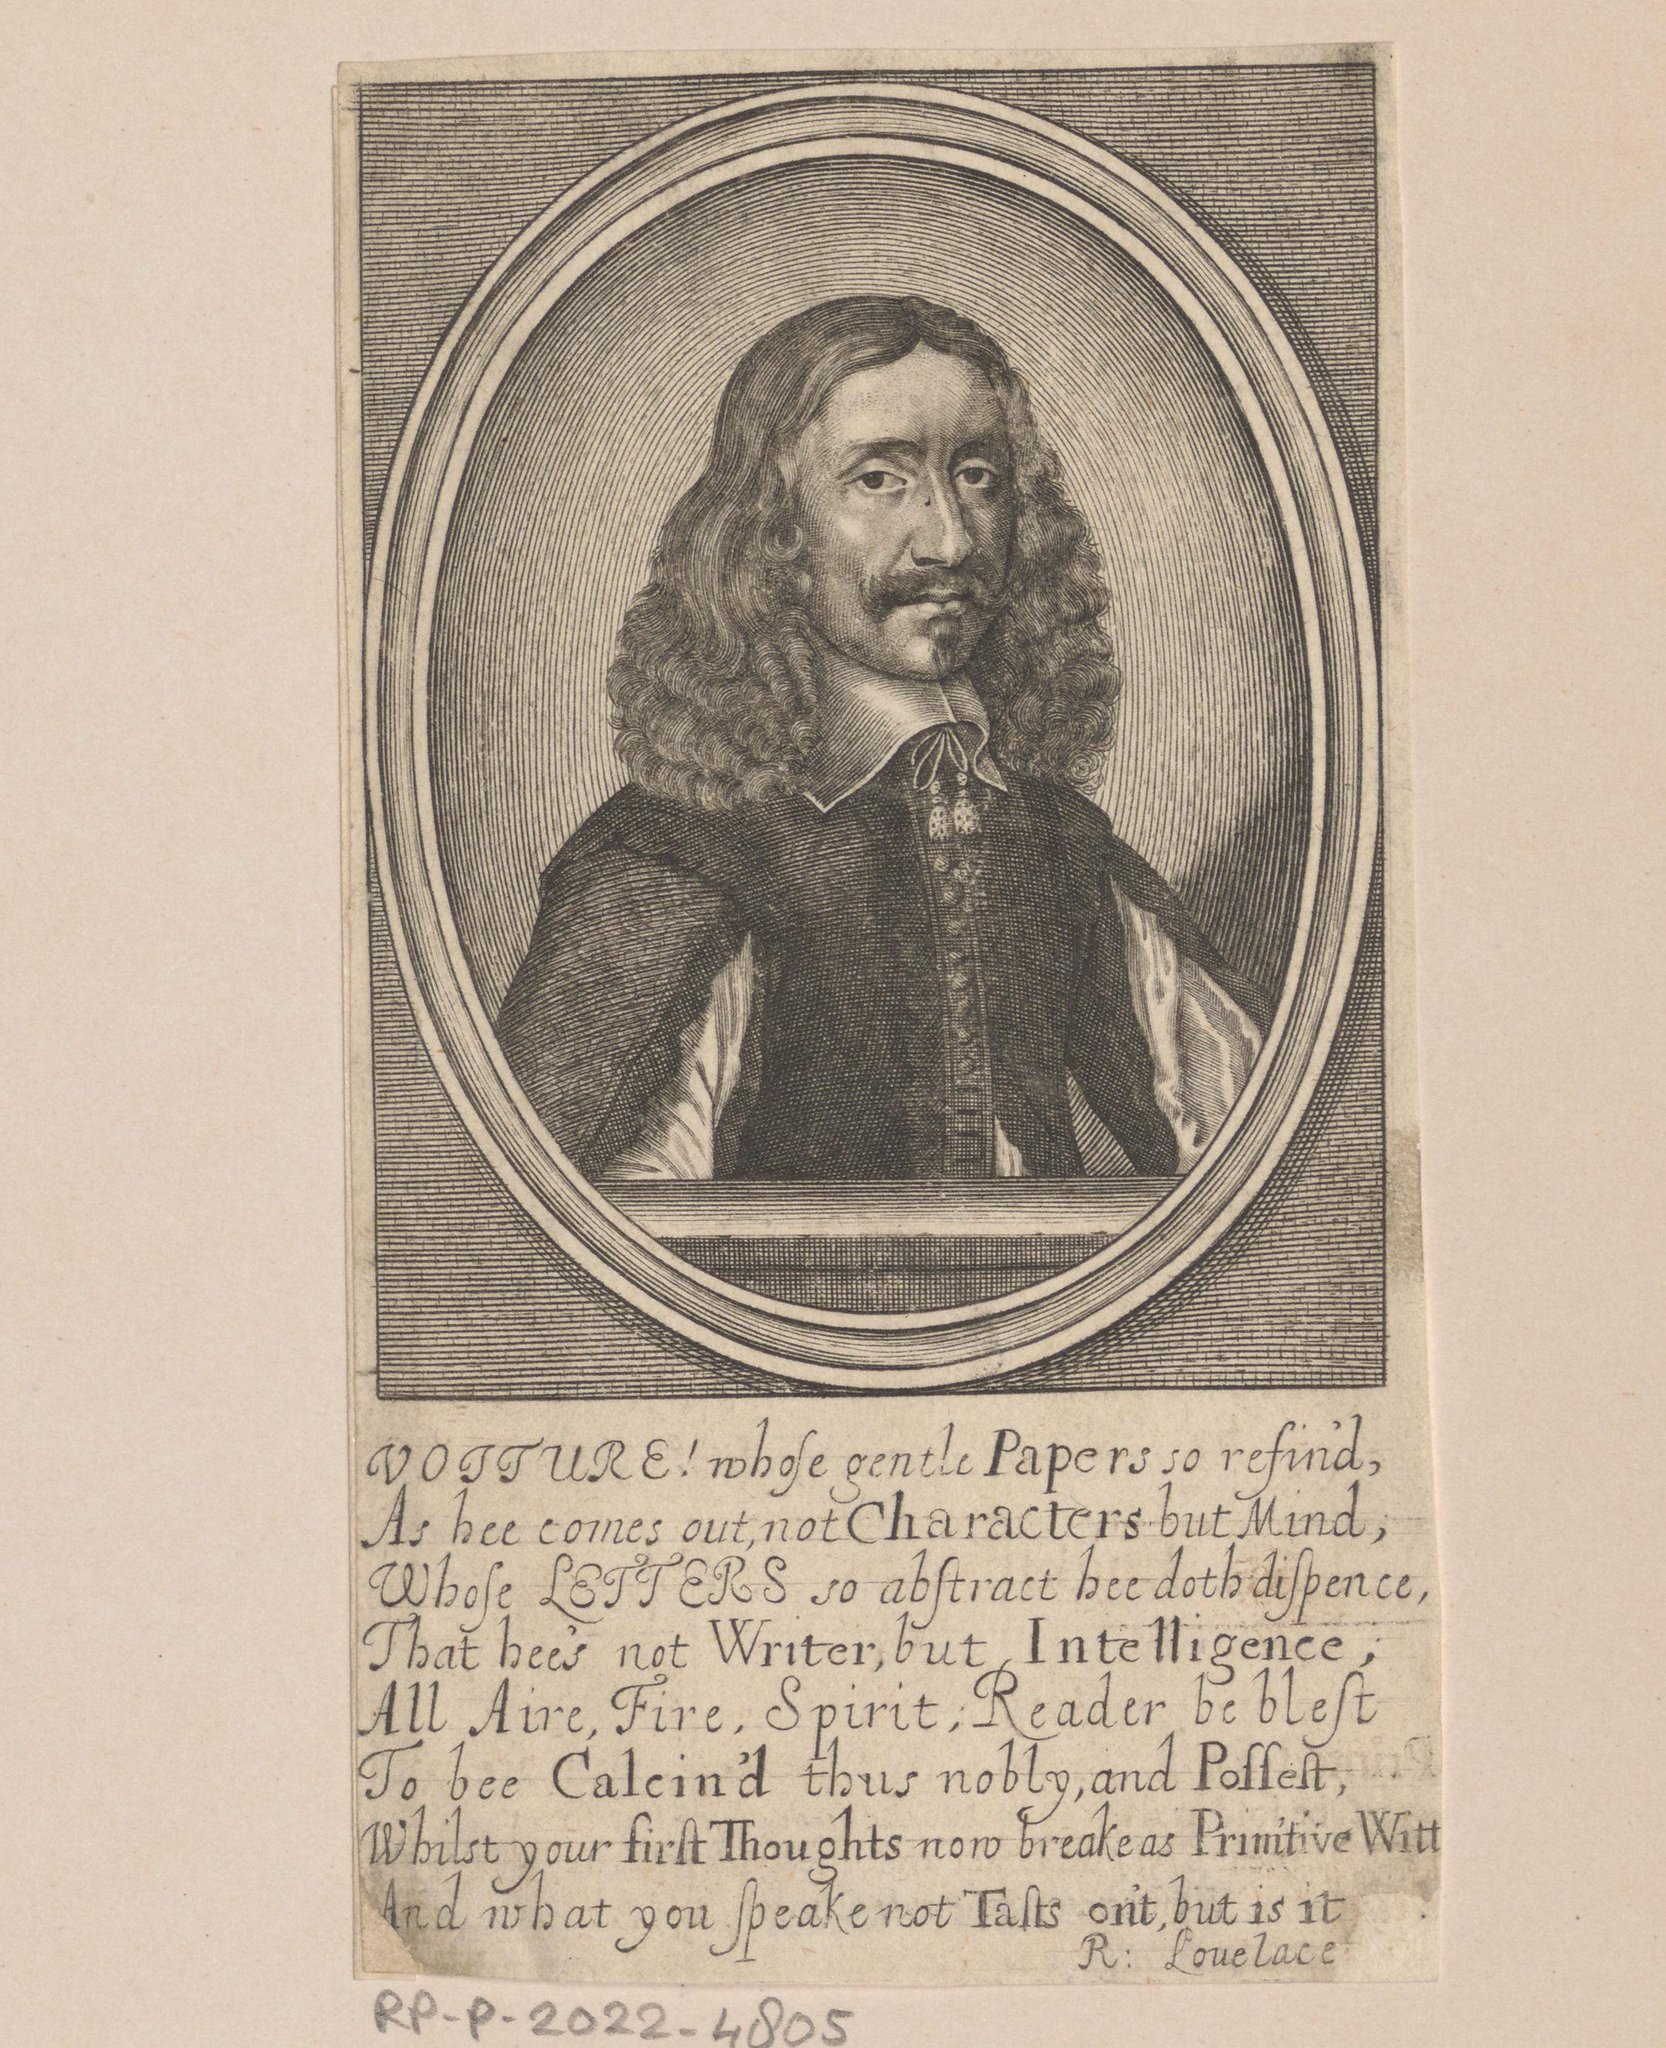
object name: print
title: Portret van Vincent Voiture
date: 1657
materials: paper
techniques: engraving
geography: england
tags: paris, historical persons, writer, poet, author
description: Prent waarschijnlijk uit: Voiture, Vincent. Letters of Affaires, Love and Courtship (...). Londen: T. Dring en J. Starkey, 1657.